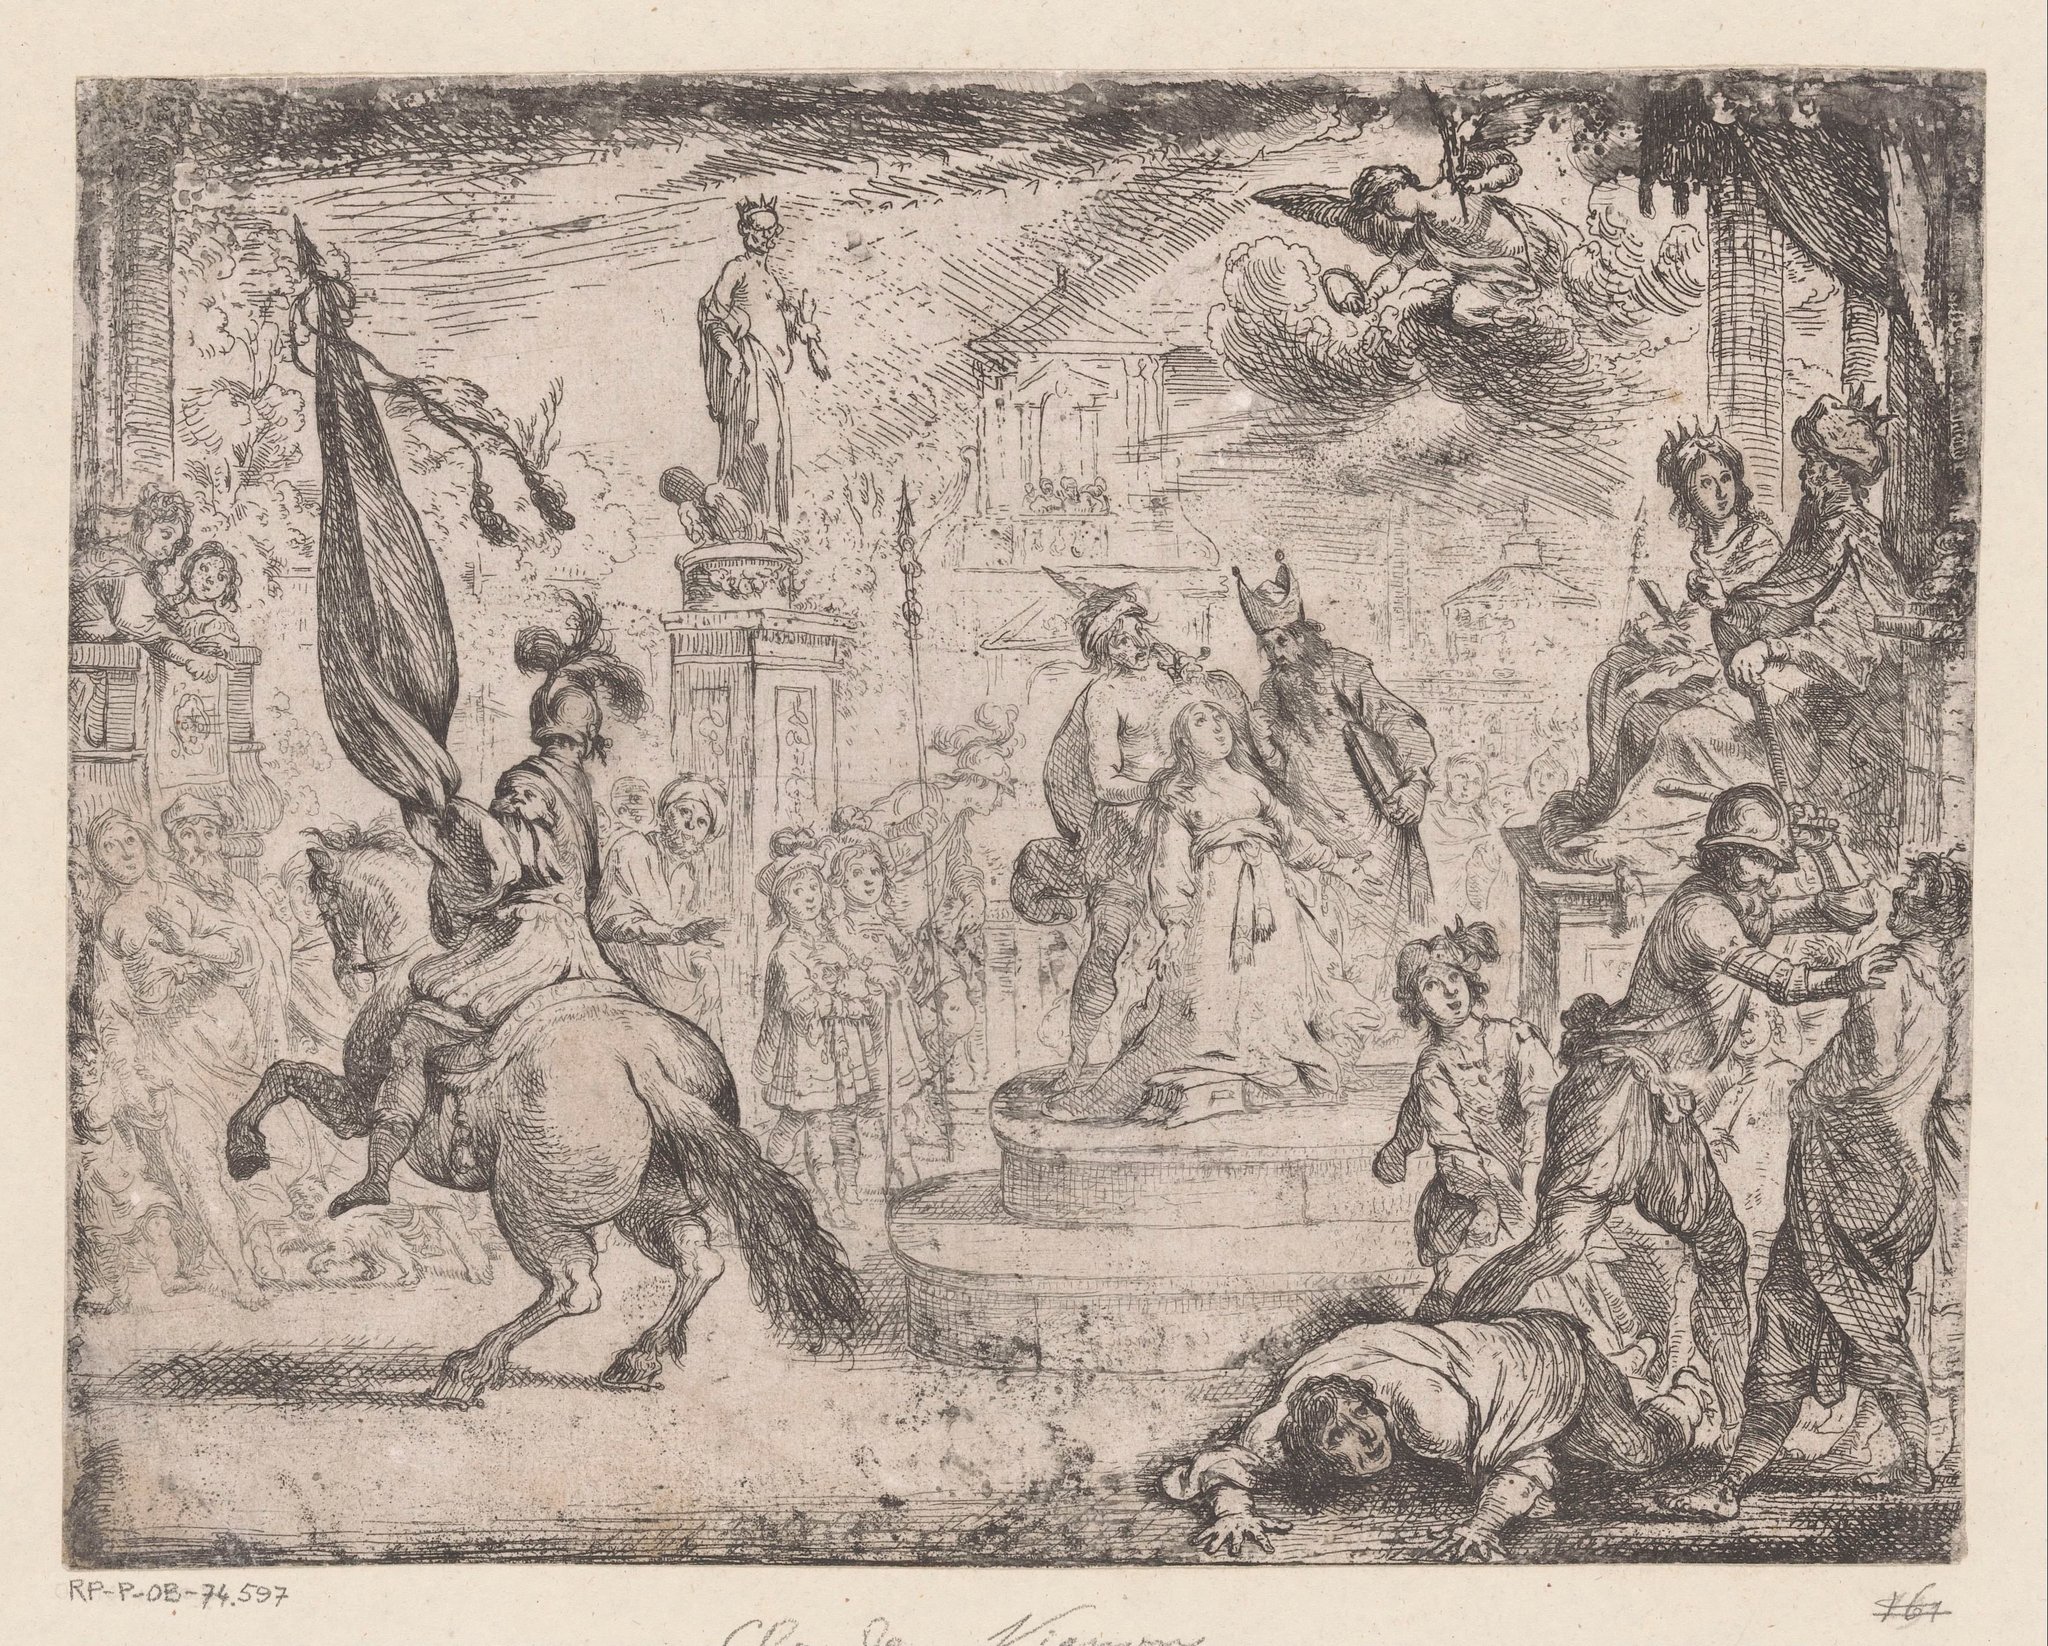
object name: print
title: Martelaarschap van de heilige Catharina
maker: claude vignon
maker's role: painter, print maker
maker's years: 1593-1670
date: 1603-1670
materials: paper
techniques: etching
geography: france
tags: the virgin martyr catherine of alexandria; possible attributes: book, crown, emperor maxentius, palm-branch, ring, sword, wheel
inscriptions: collector's mark: Lugt 240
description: Volgens Robert-Dumesnil (1835-1871) en LeBlanc (1854-1889) wordt op deze ets het martelaarschap van de heilige Lucia afgebeeld. Volgens Thuillier (e.a.) (1993) wijst het object aan de knieën van de heilige echter op resten van het rad waarop Catharina werd gemarteld. Deze compositie komt overeen met een gesigneerd en 1627 gedateerd schilderij door Vignon, waarvan de huidige locatie onbekend is. Ook is een tekening met dezelfde compositie bekend die wordt beschouwd als een kopie uit Vignons atelier. Deze tekening bevindt zich in de Bibliothèque Nationale te Parijs, inv. nr. B6.